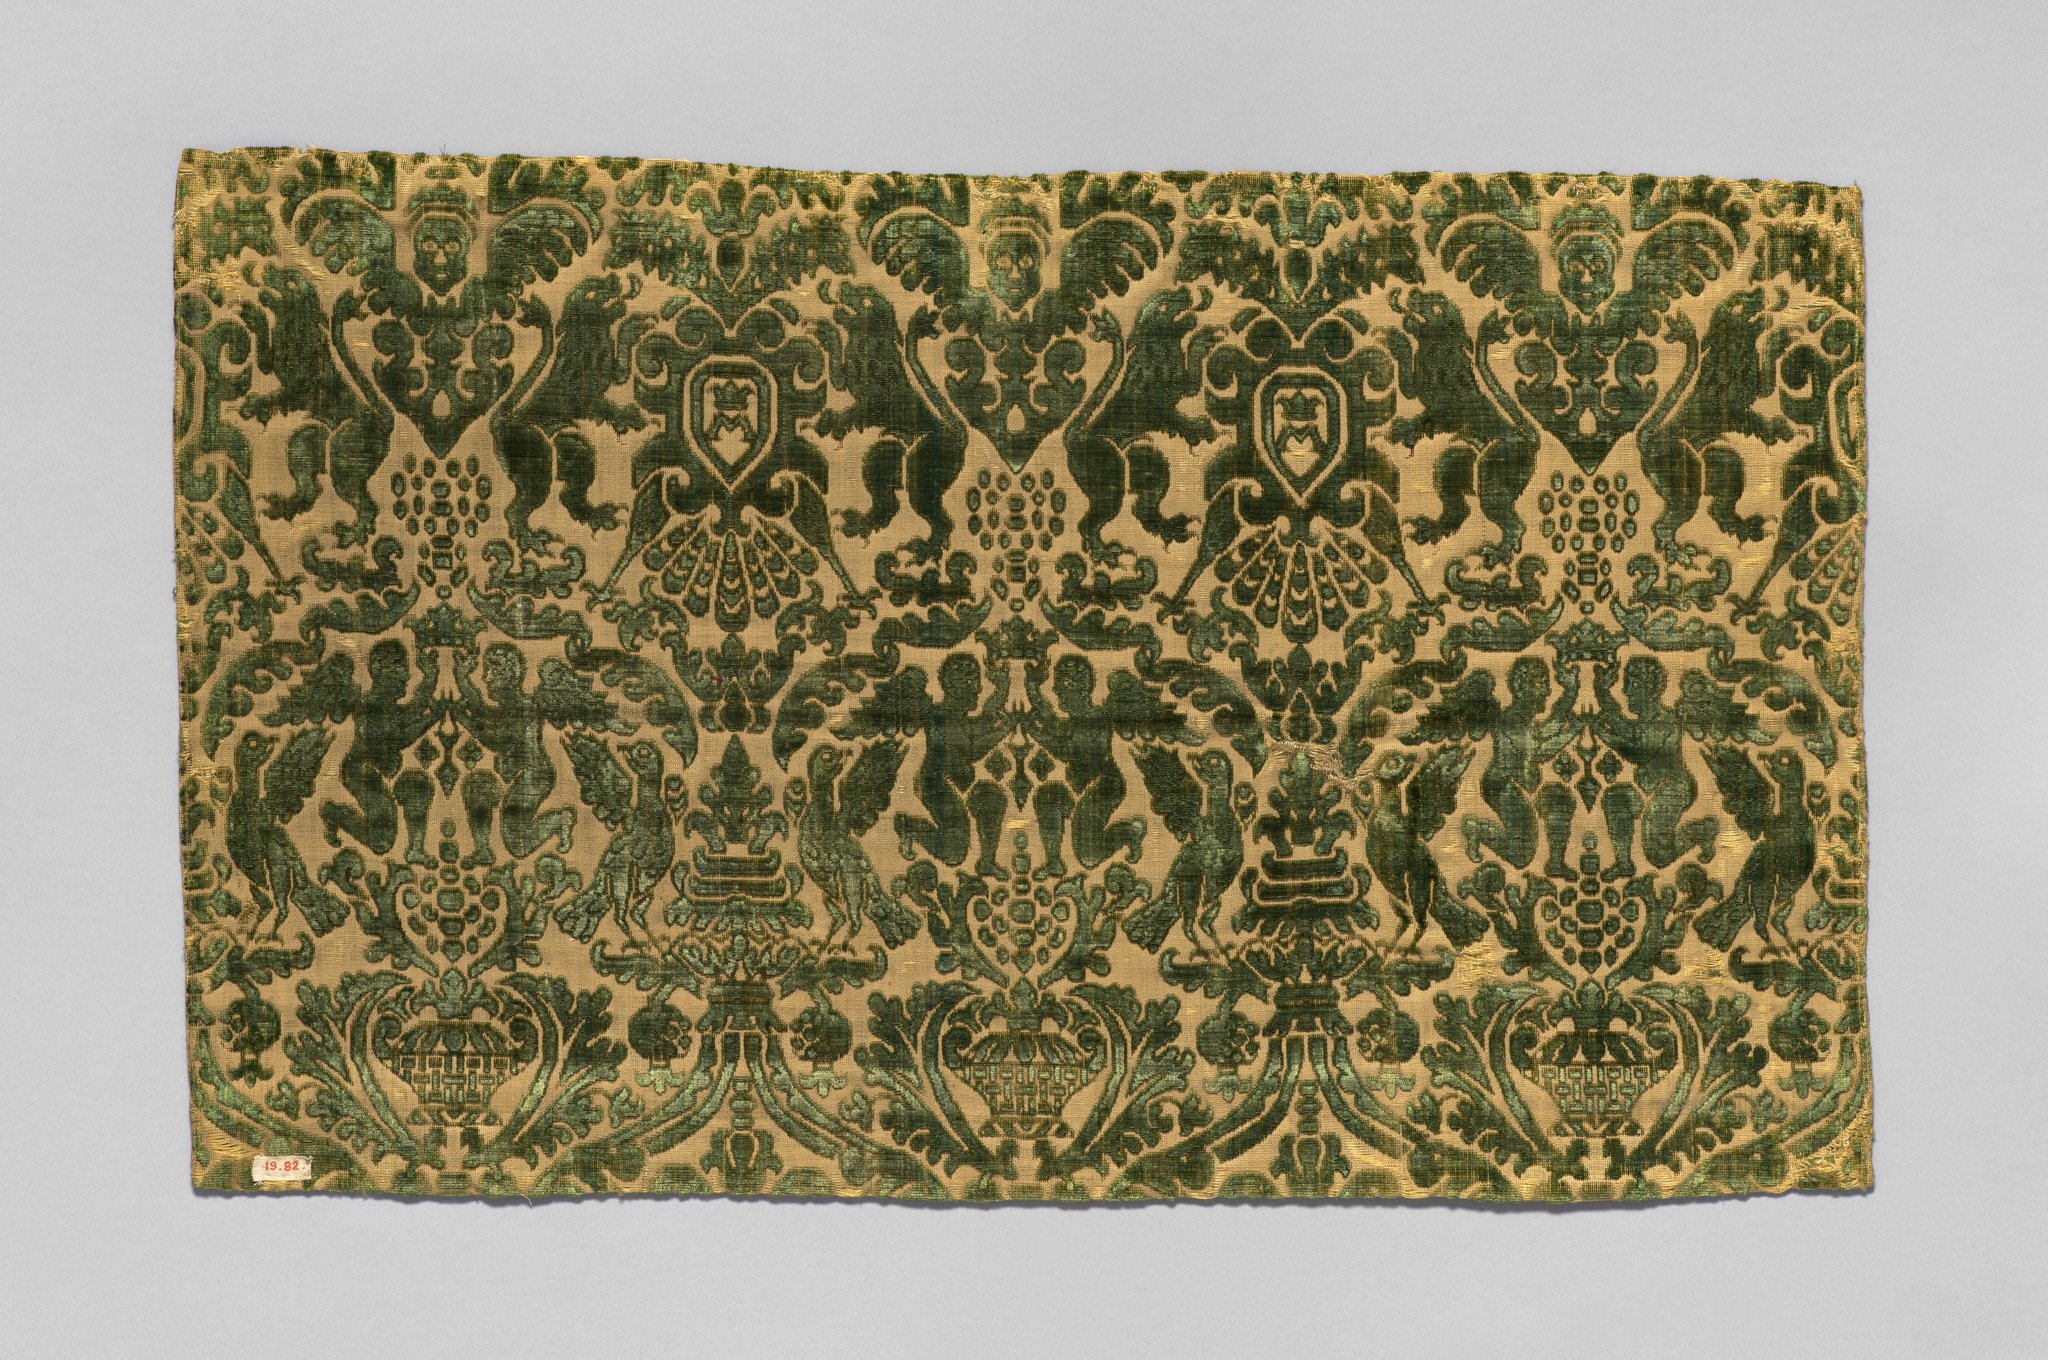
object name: piece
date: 1501-1600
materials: silk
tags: birds,putti,lions